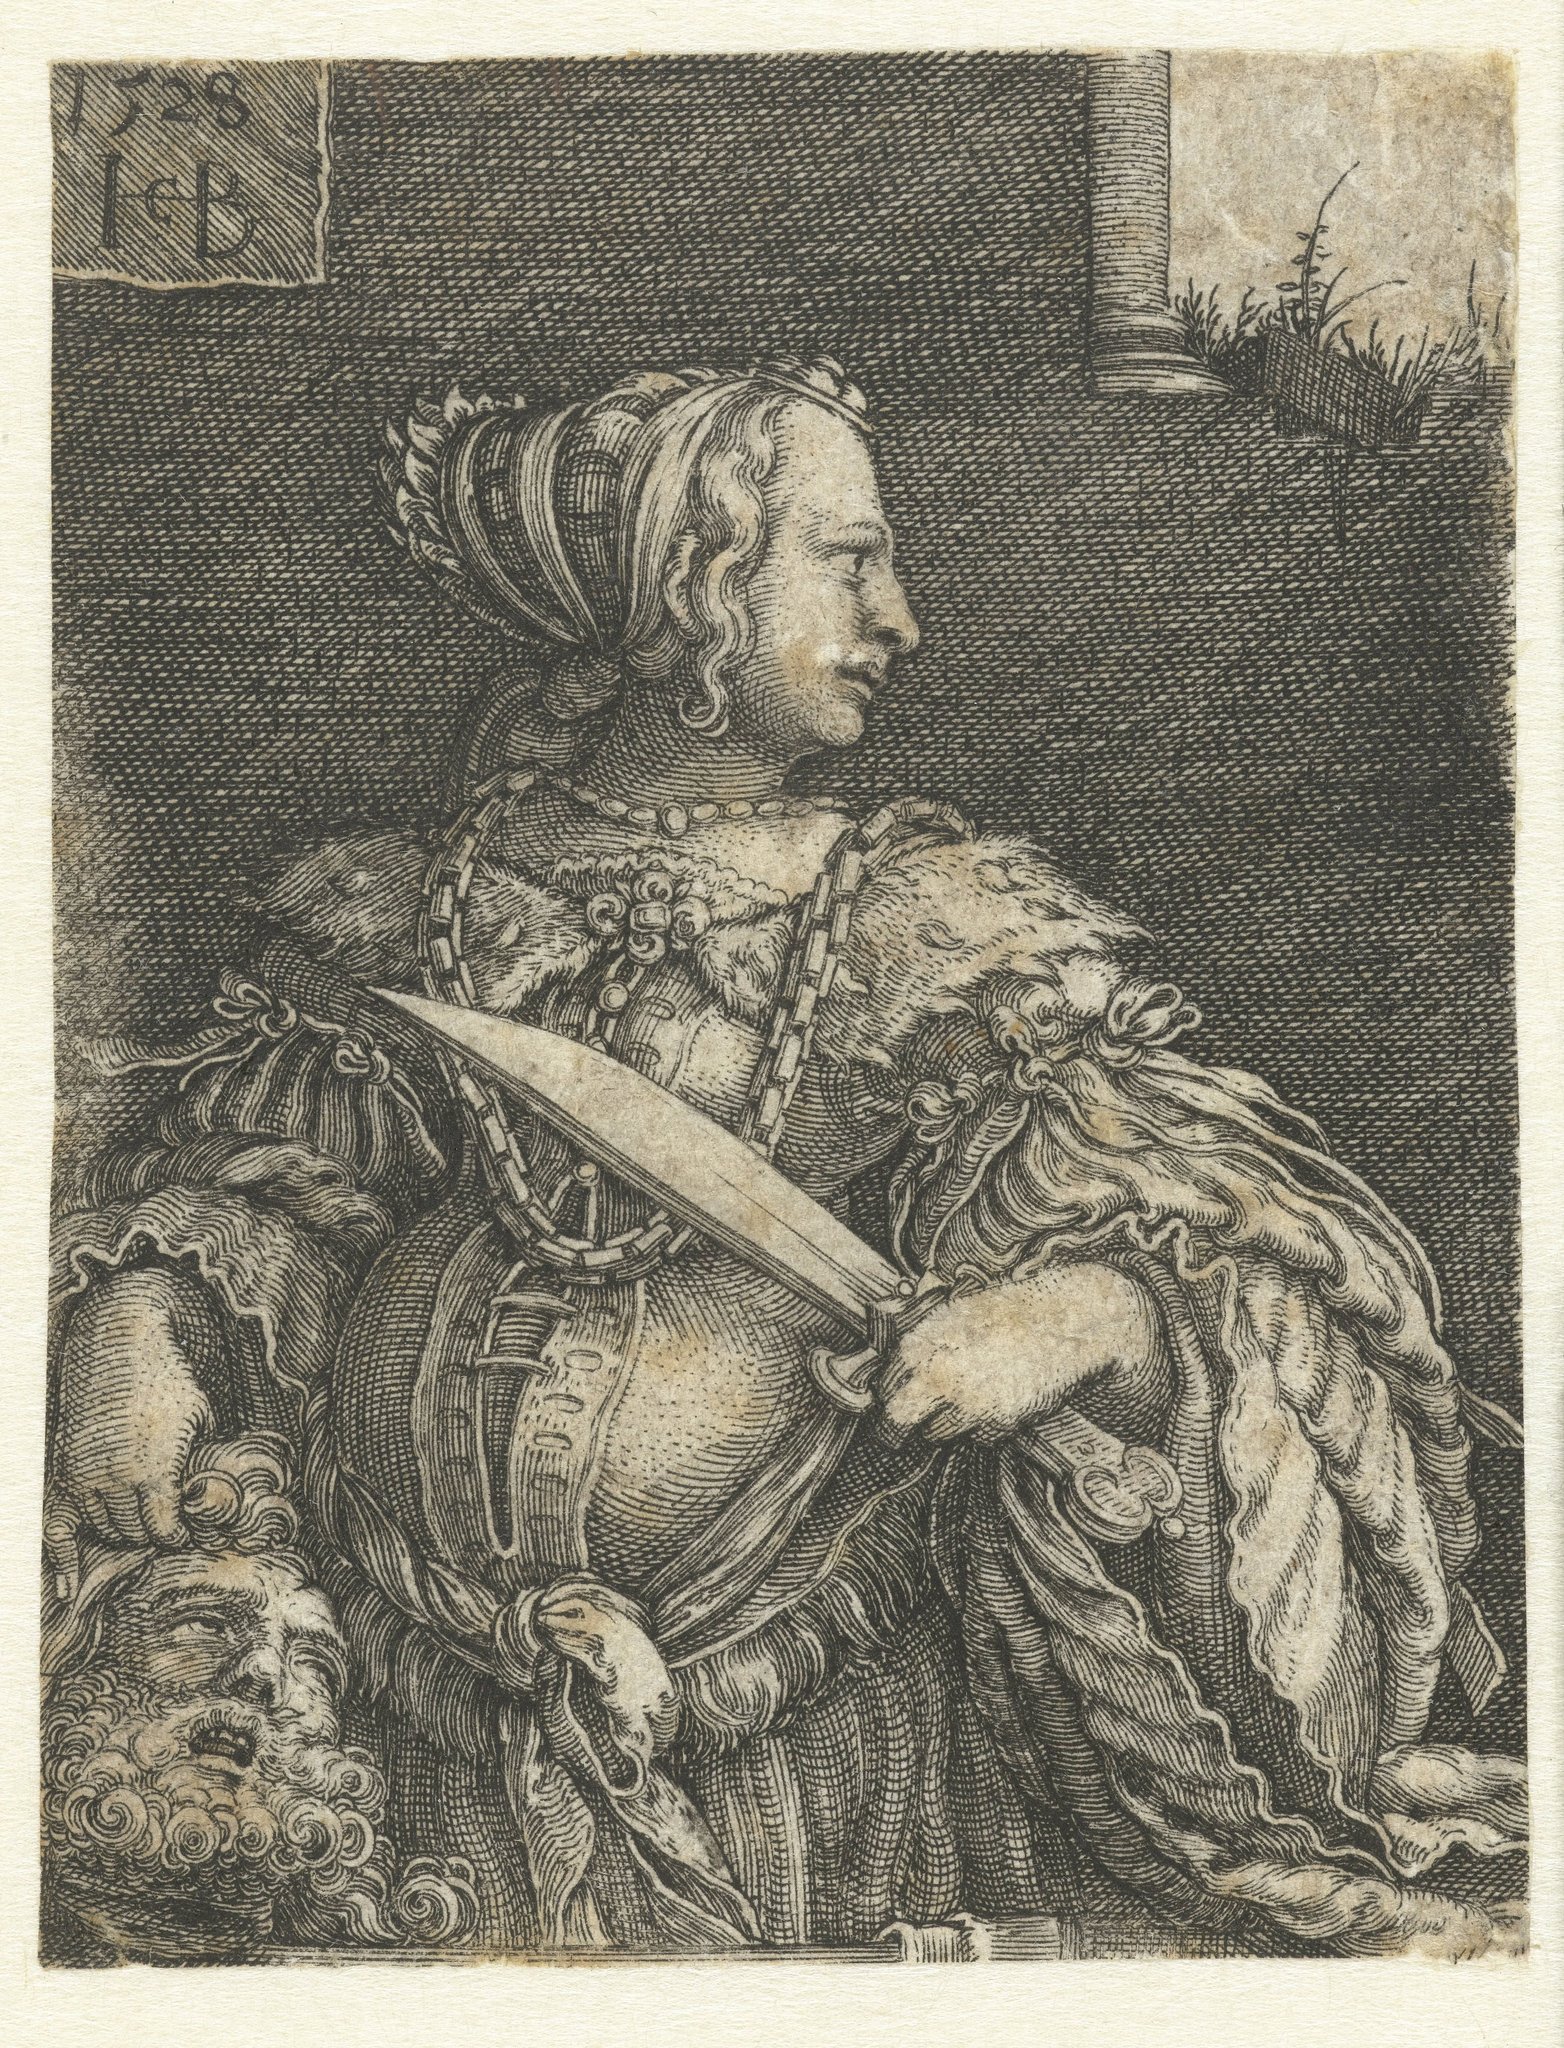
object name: print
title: Judith met het hoofd van Holofernes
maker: jacob binck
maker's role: painter, print maker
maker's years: 1494-1569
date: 1528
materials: paper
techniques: engraving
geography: germany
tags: judith and holofernes (judith 8-16)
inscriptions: collector's mark: Lugt 2228a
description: Nauwkeurige kopie in spiegelbeeld naar een prent van Barthel Beham.